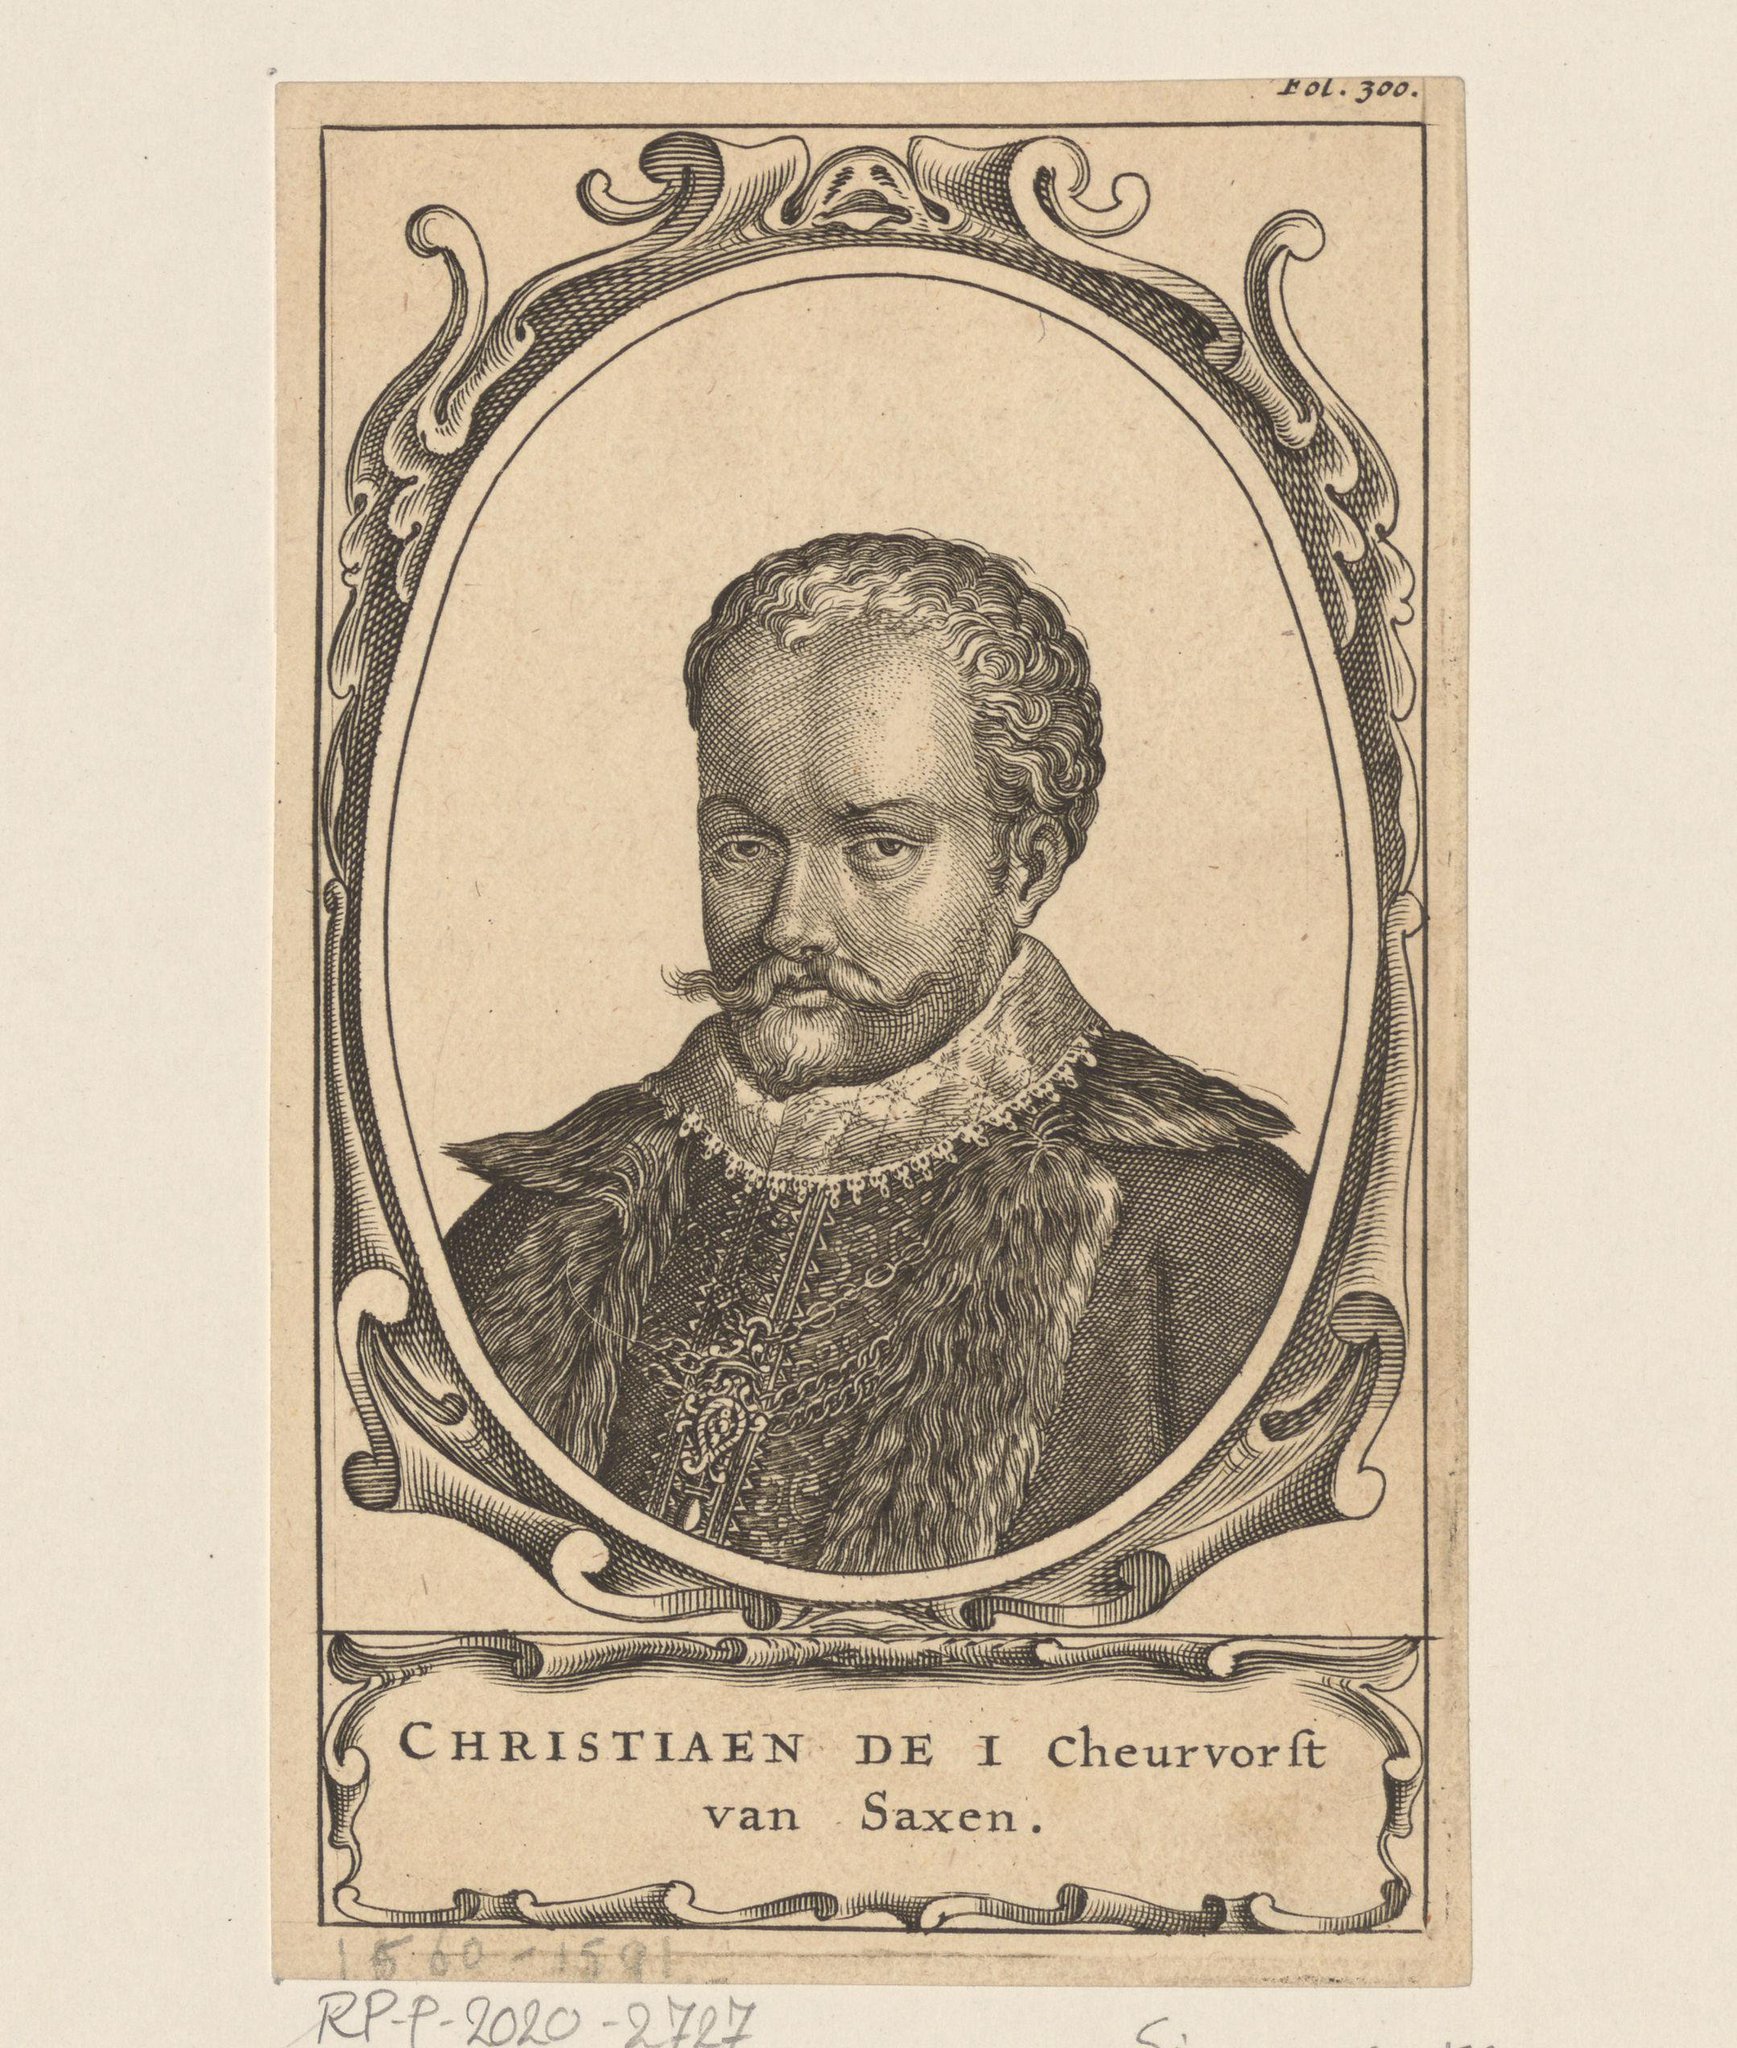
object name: print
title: Portret van Christiaan I van Saksen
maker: Anonymous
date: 1659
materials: paper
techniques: engraving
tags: historical persons, king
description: Prent waarschijnlijk uit: Corput, Abraham van den. De goddelicke vierschare, dat is ontdeckinge der hemelsche oordelen. Utrecht: Johannes Janssonius van Waesberge I, 1659, dl. 1, p. 300. Prent ook gebruikt in latere edities.